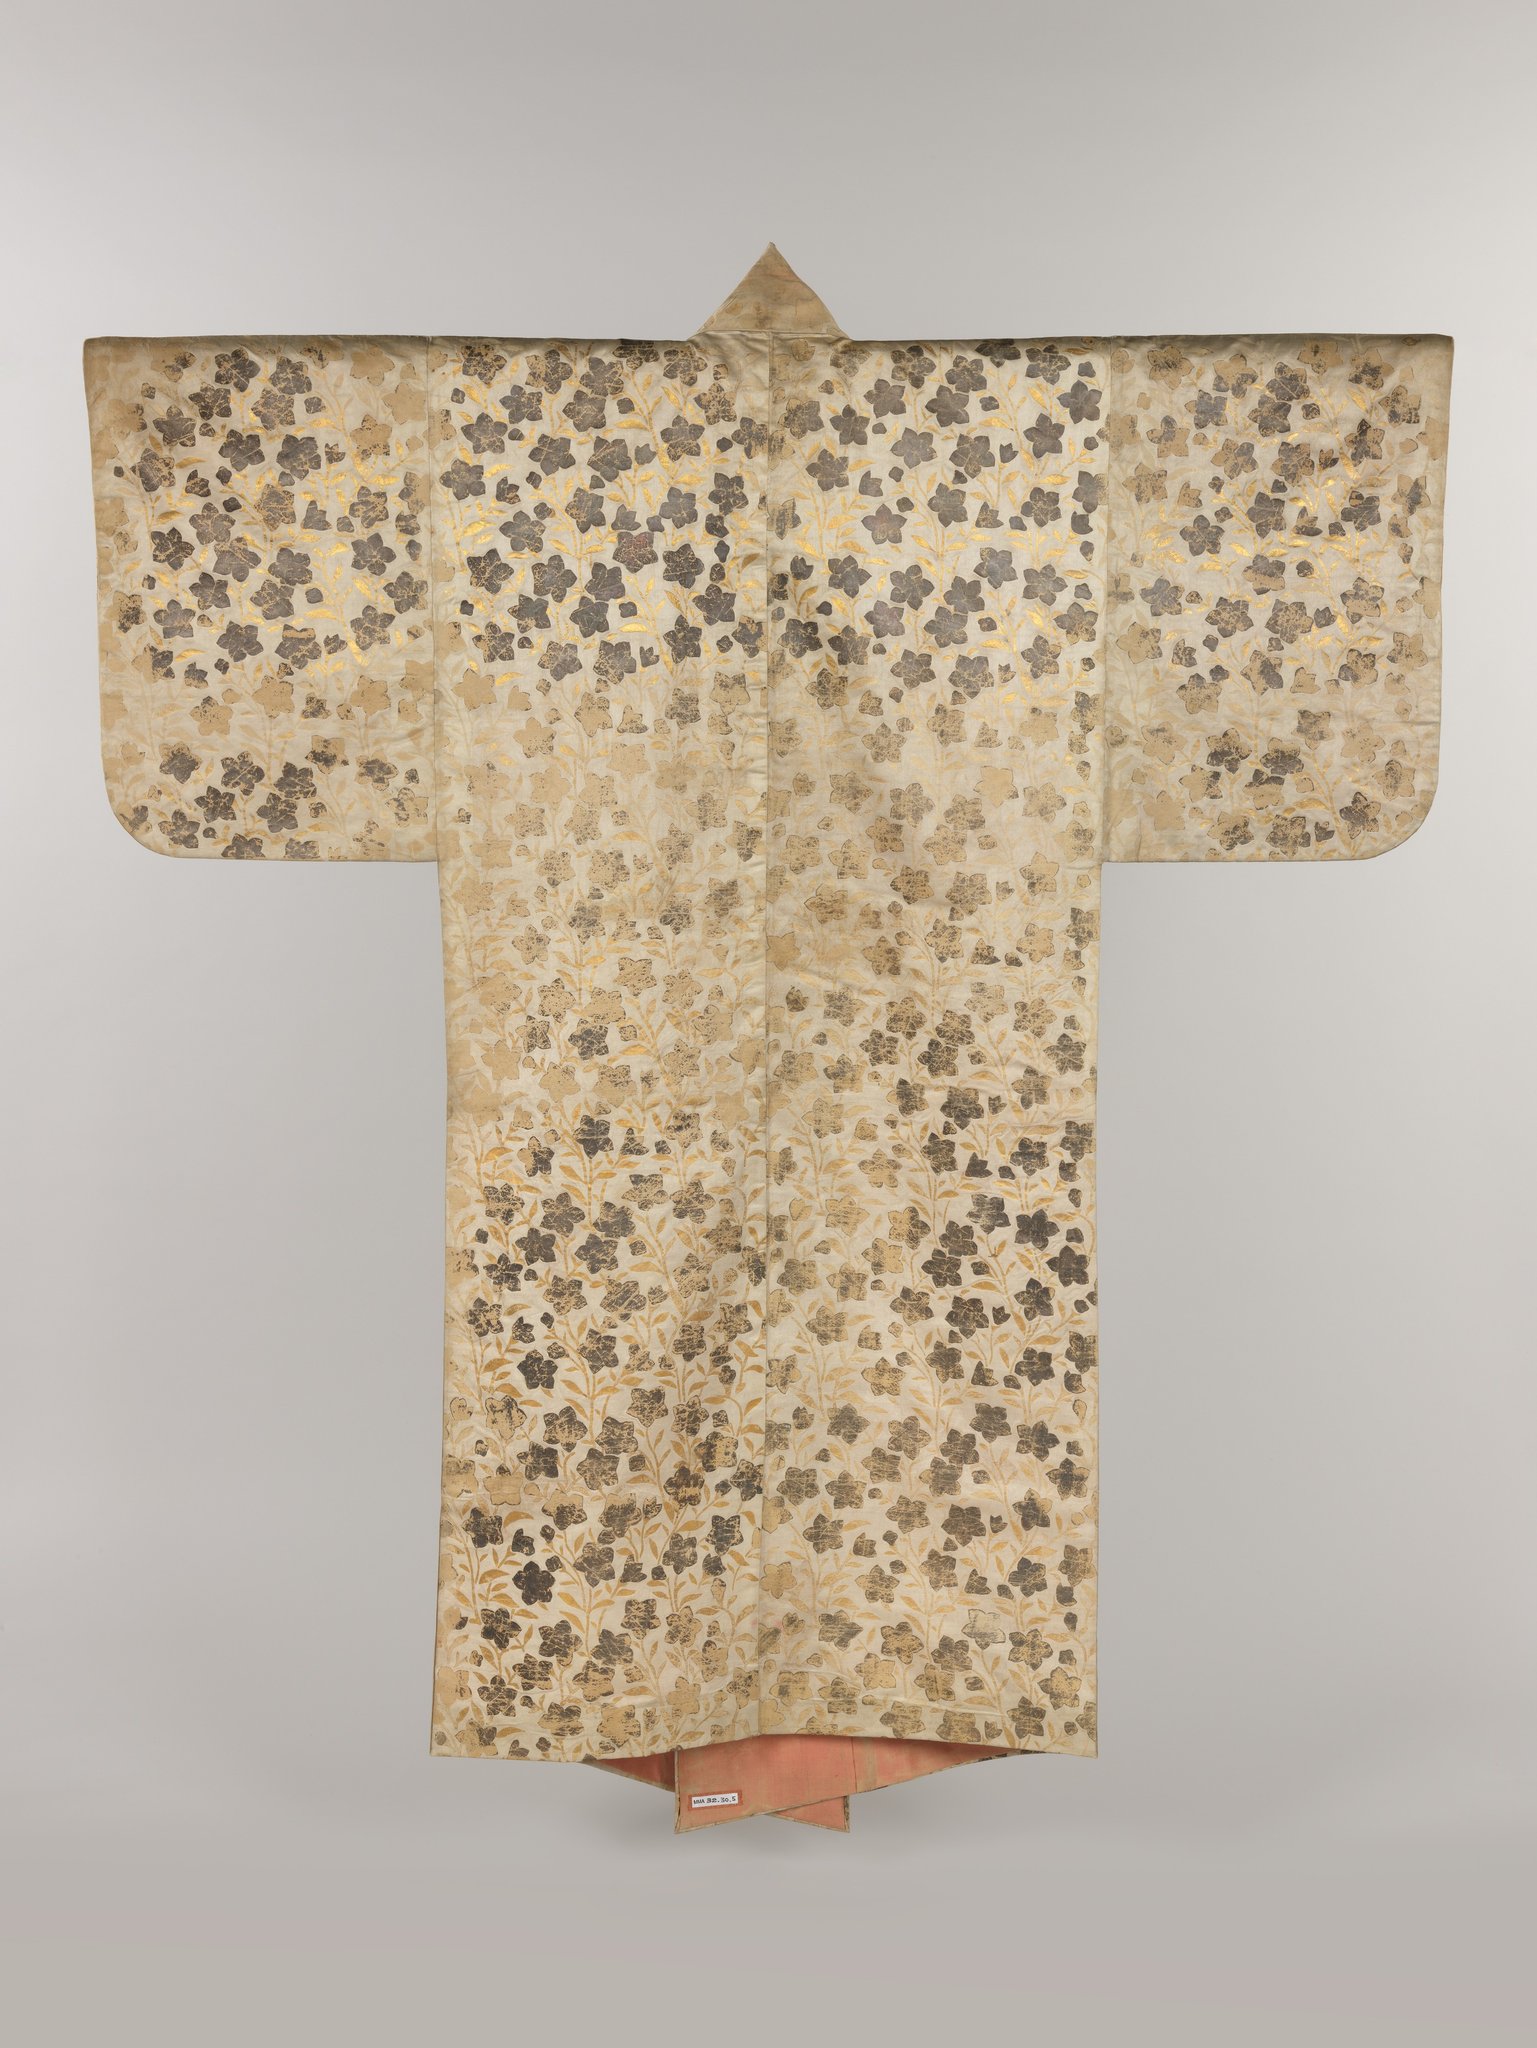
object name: noh costume surihaku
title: Noh Costume (Surihaku) with Chinese Bellflowers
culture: japanese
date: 1701-1800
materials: gold, silk, silver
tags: leaves